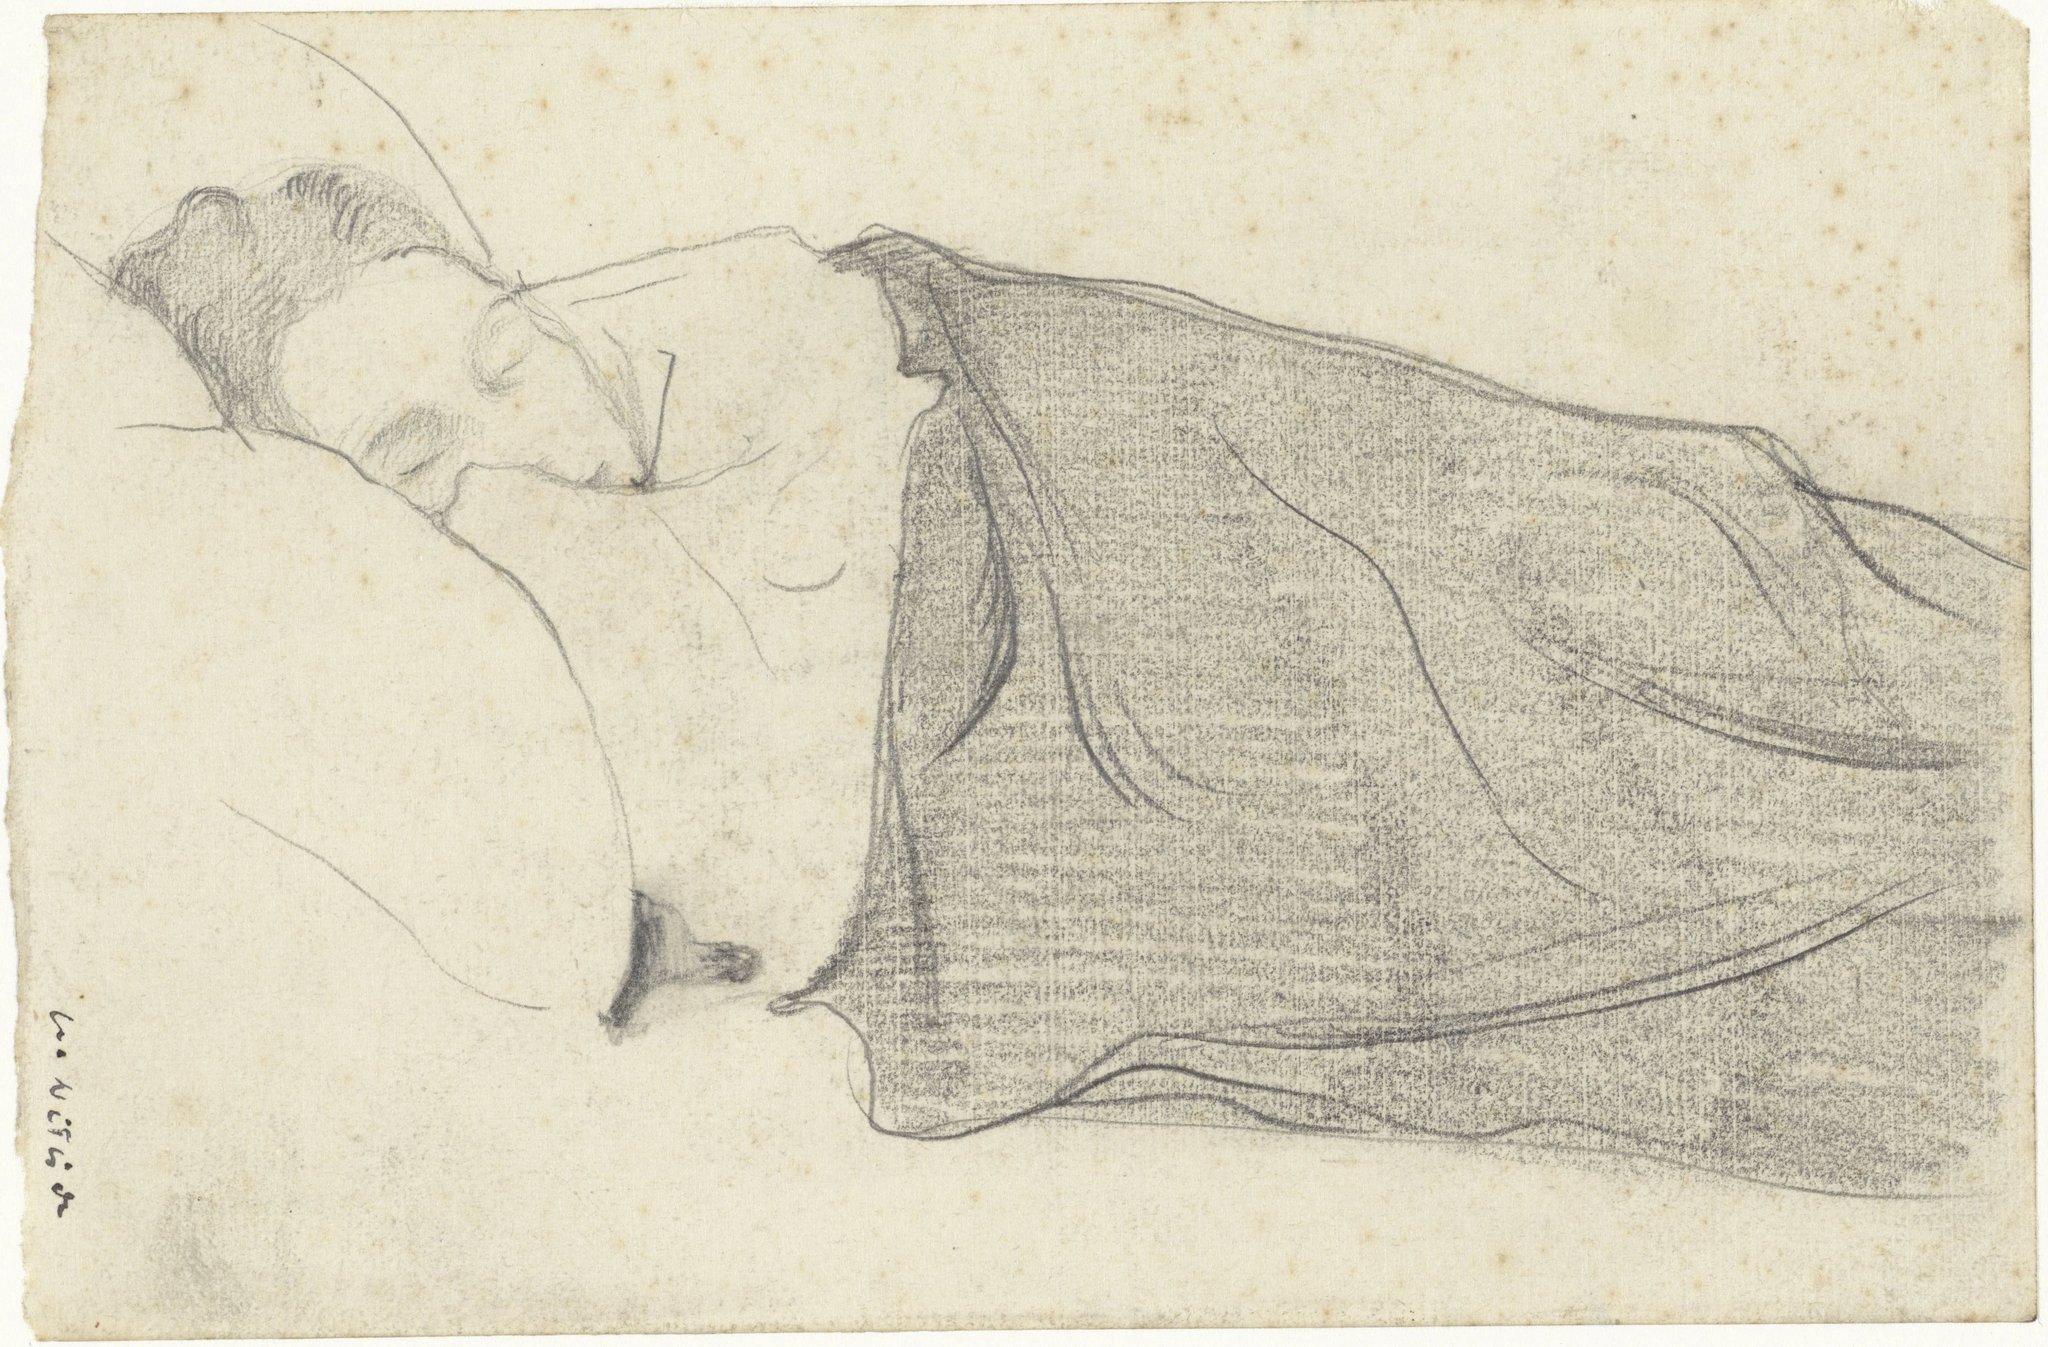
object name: drawing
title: Vrouw van Richard Roland Holst in bed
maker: richard nicolaüs roland holst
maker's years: 1868-1938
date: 1878-1938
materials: paper, pencil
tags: amsterdam, henriëtte roland holst-van der schalk, historical persons - bb - woman, sleeping; unconsciousness